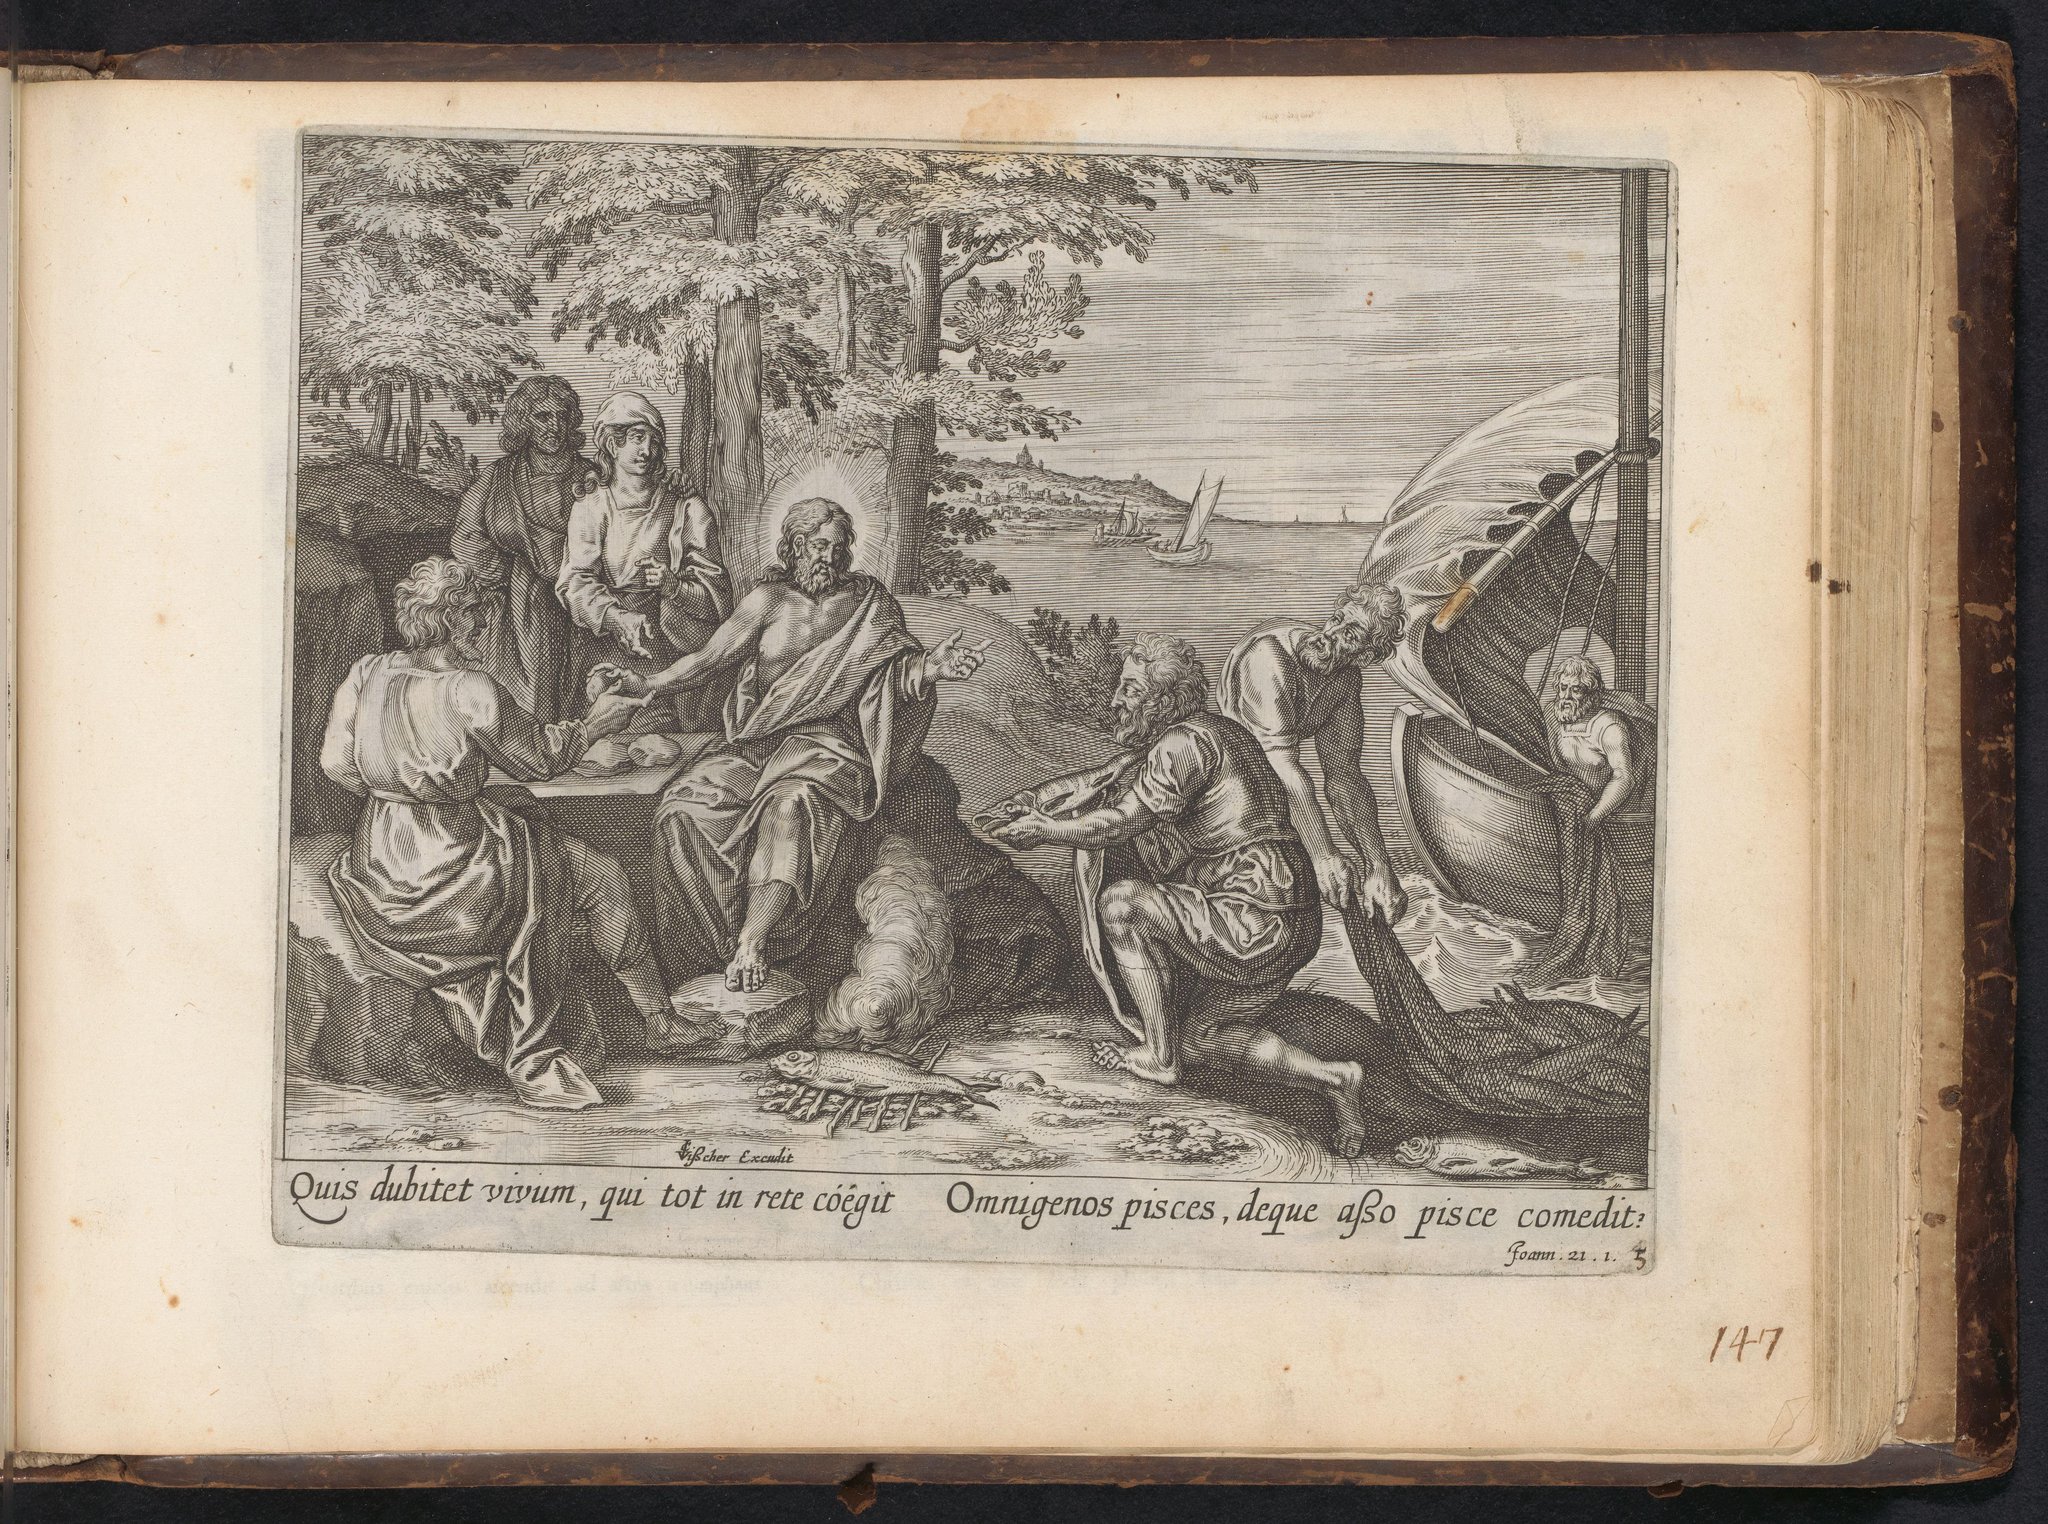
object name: album leaf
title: Christus verschijnt bij het Meer van Tiberias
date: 1646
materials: paper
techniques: engraving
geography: alkmaar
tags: christ gives fish and bread to the apostles, the catch is brought ashore: peter carries the heavy net with fishes ~ lake of gennesaret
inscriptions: number: ‘147’, serial number: ‘5’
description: Christus verschijnt aan de apostelen aan de oever van het Meer van Tiberias. Hij deelt het brood. Petrus biedt een van de gevangen vissen aan. Onder de voorstelling een verwijzing in het Latijn naar de Bijbeltekst in Joh. 21:1. Deze prent maakt deel uit van een album.